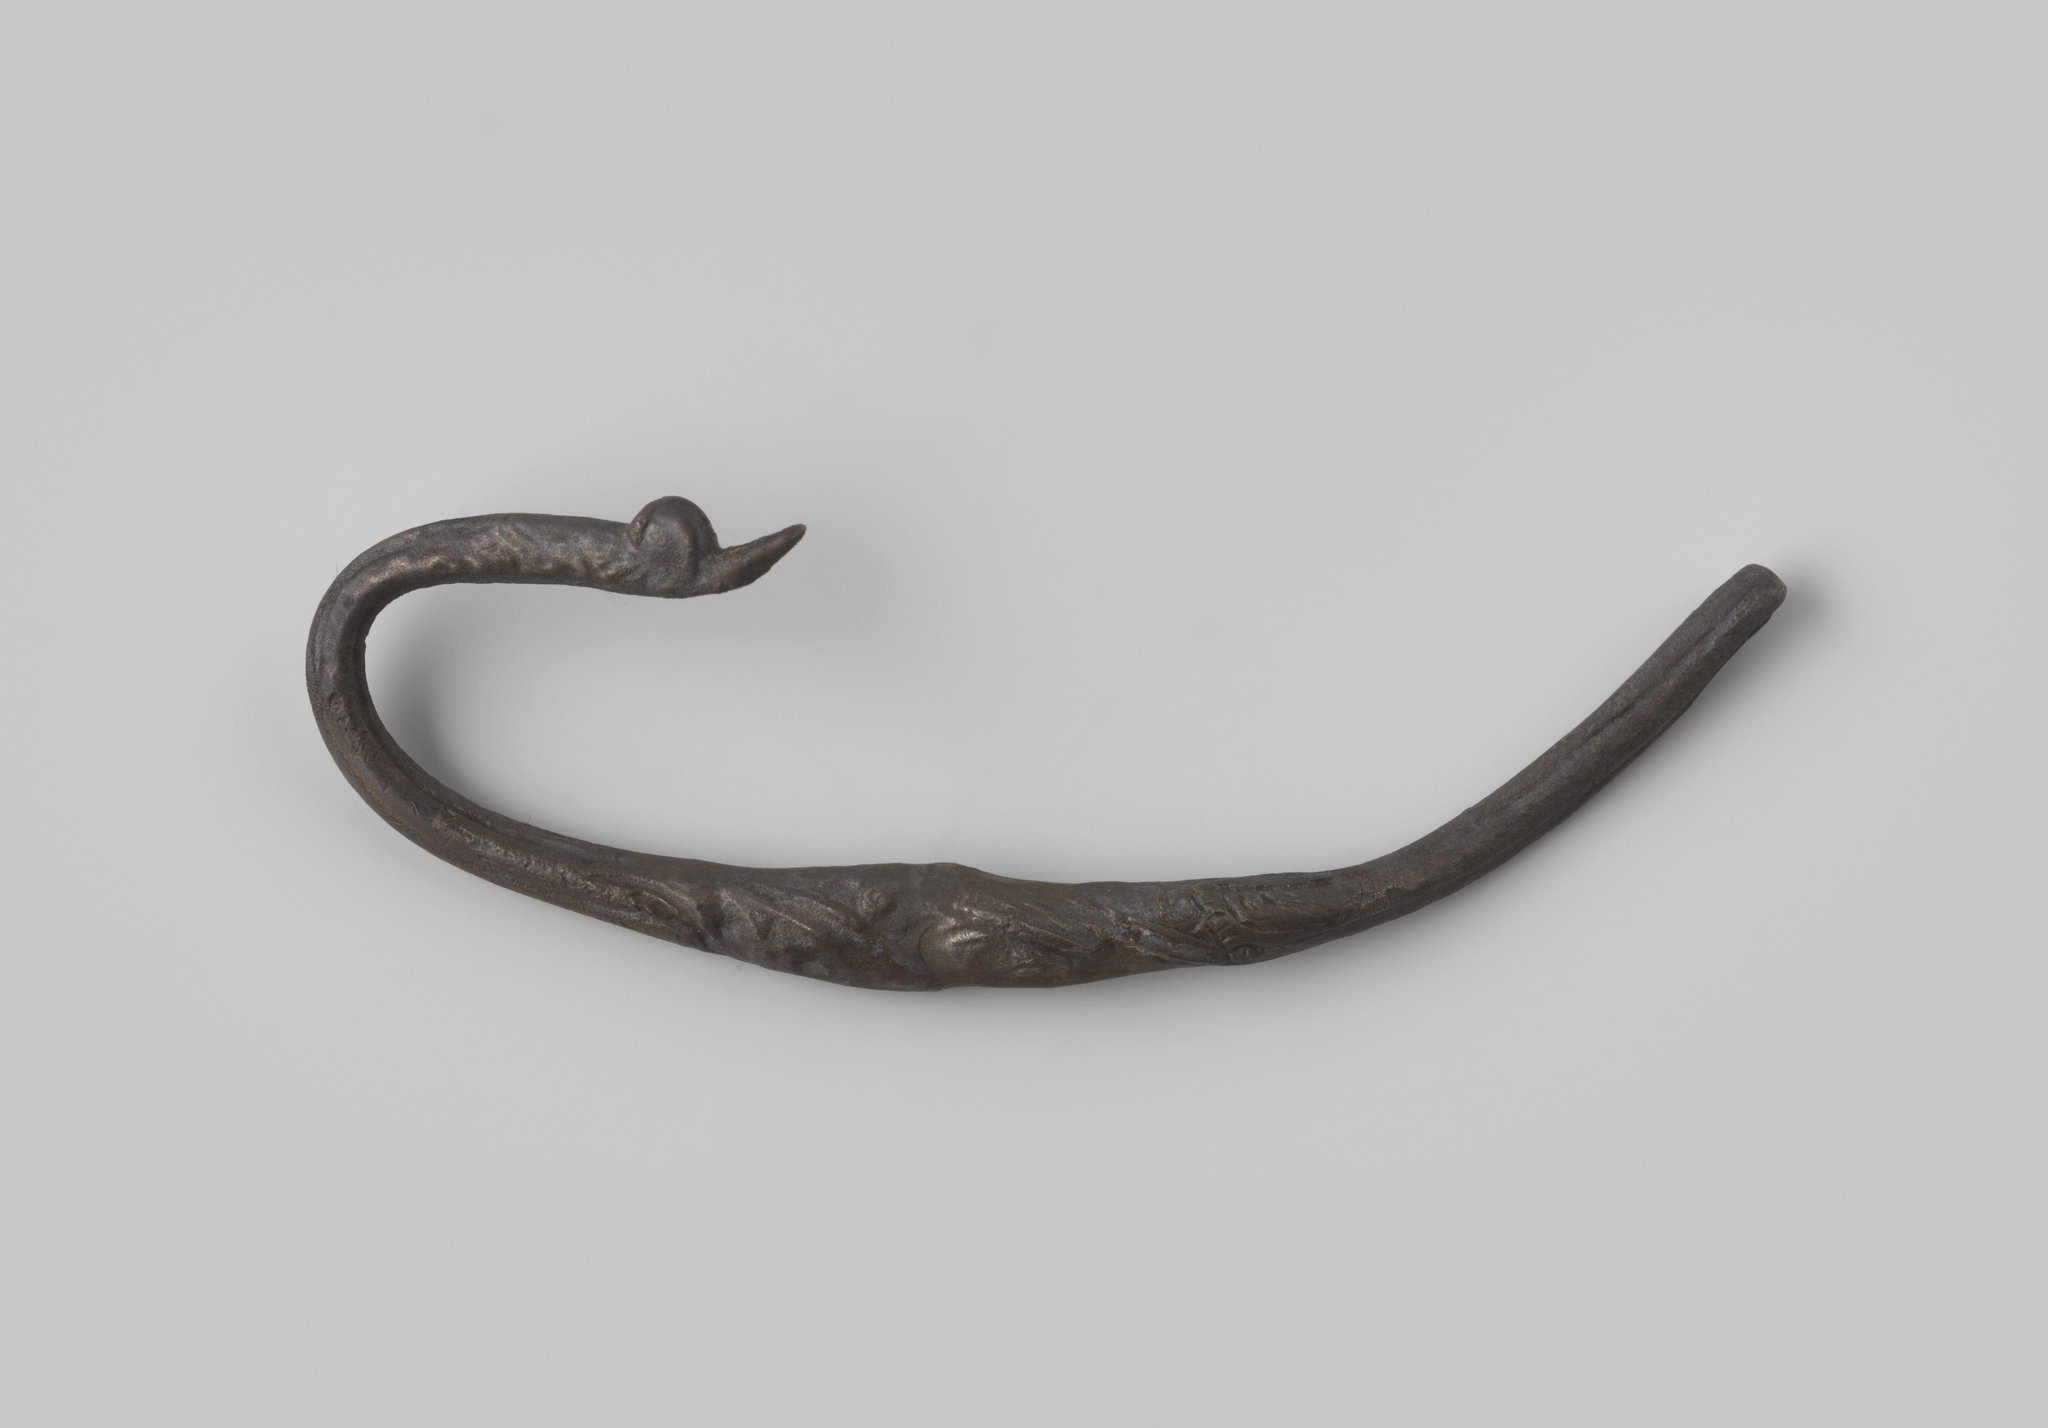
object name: beugel gevestl, gevestbeugel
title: Fragment beugel van gevest uit het wrak van de Oost-Indiëvaarder Hollandia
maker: Anonymous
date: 1700-1743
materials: silver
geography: netherlands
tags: verenigde oostindische compagnie, hollandia (schip), annet